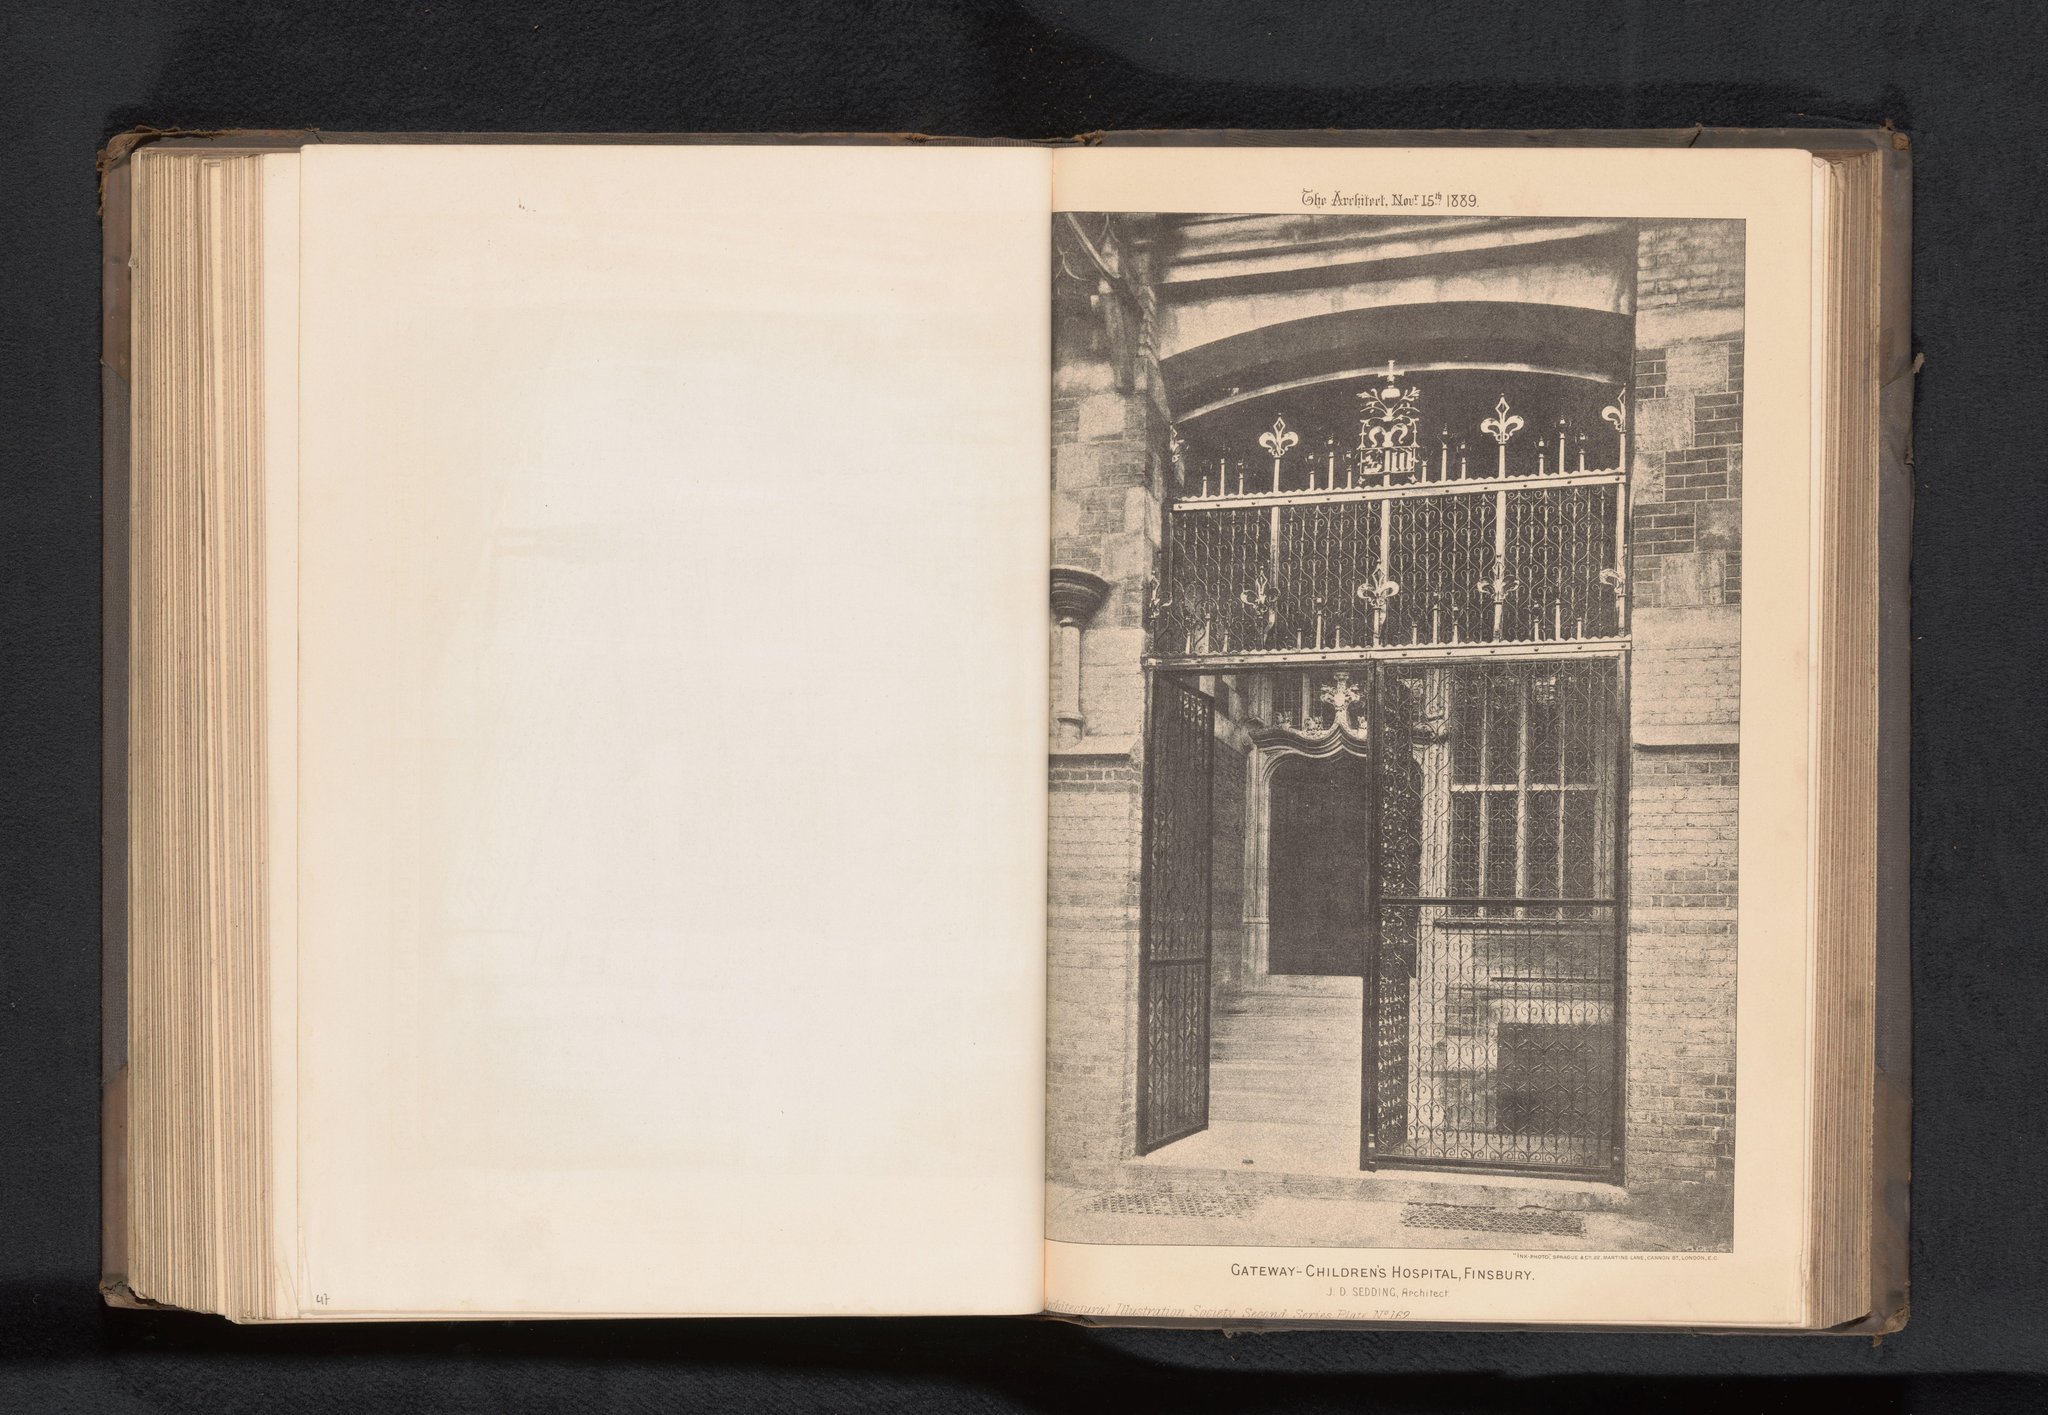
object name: photomechanical print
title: Poort van het kinderziekenhuis te Finsbury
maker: Anonymous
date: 1884-1889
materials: paper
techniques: photolithography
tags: gate, entrance, hospital, london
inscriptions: inscription: ‘J.D. Sedding, Architect/ Architectural Illustration Society. Second Series. Plate No.162’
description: Prent op negende ongenummerde pagina na pagina 284.